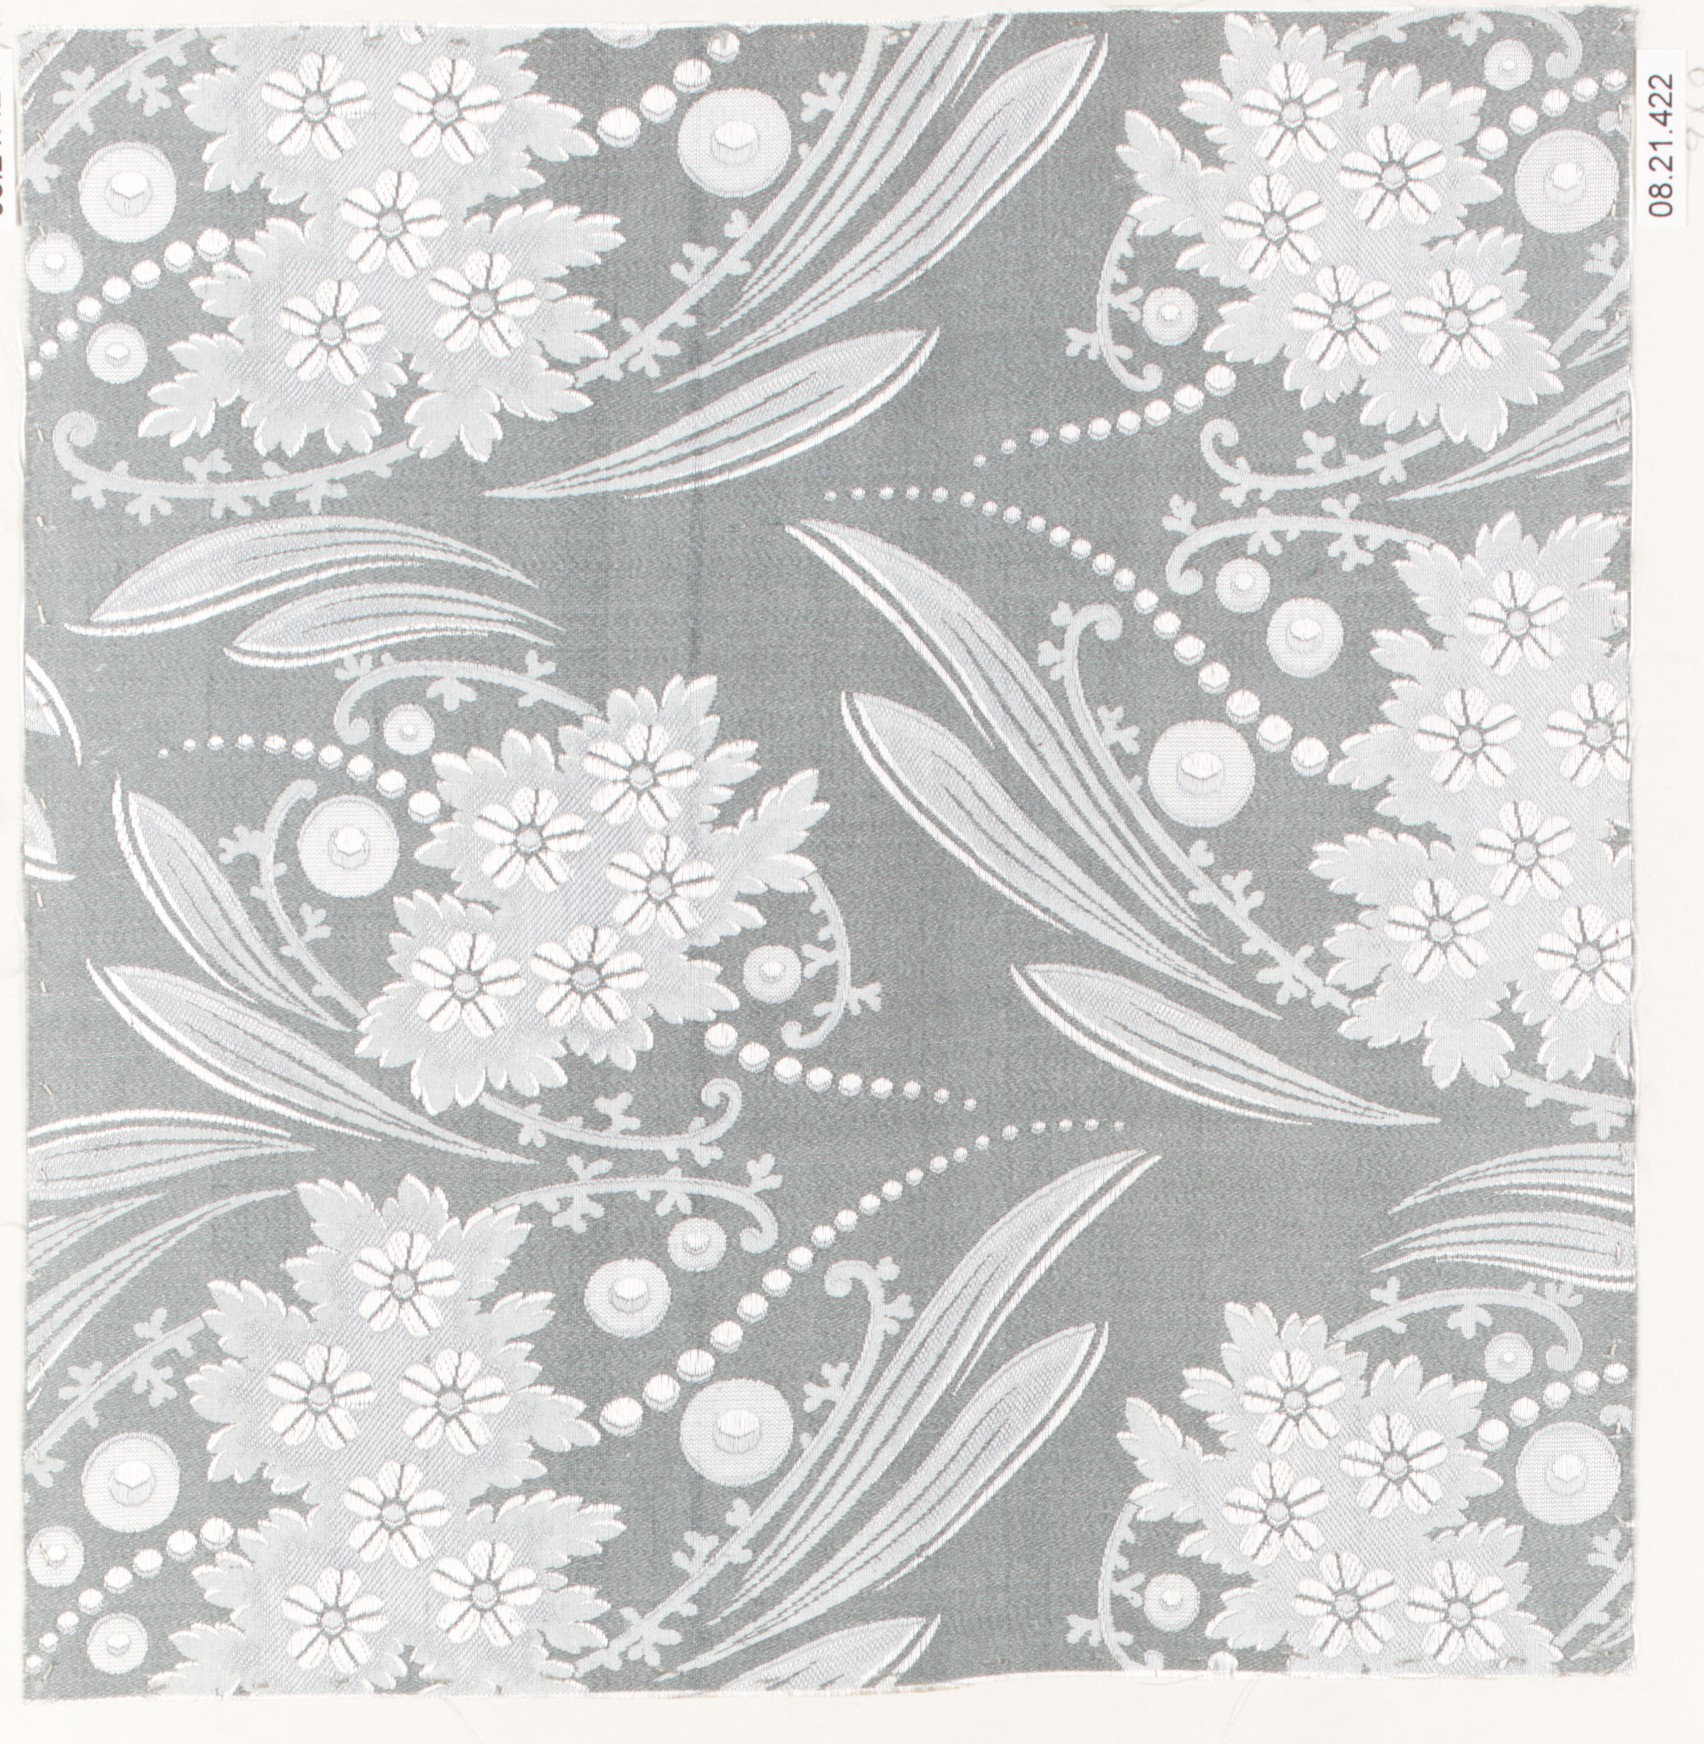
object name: textile sample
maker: Anonymous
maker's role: designer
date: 1900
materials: silk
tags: flowers